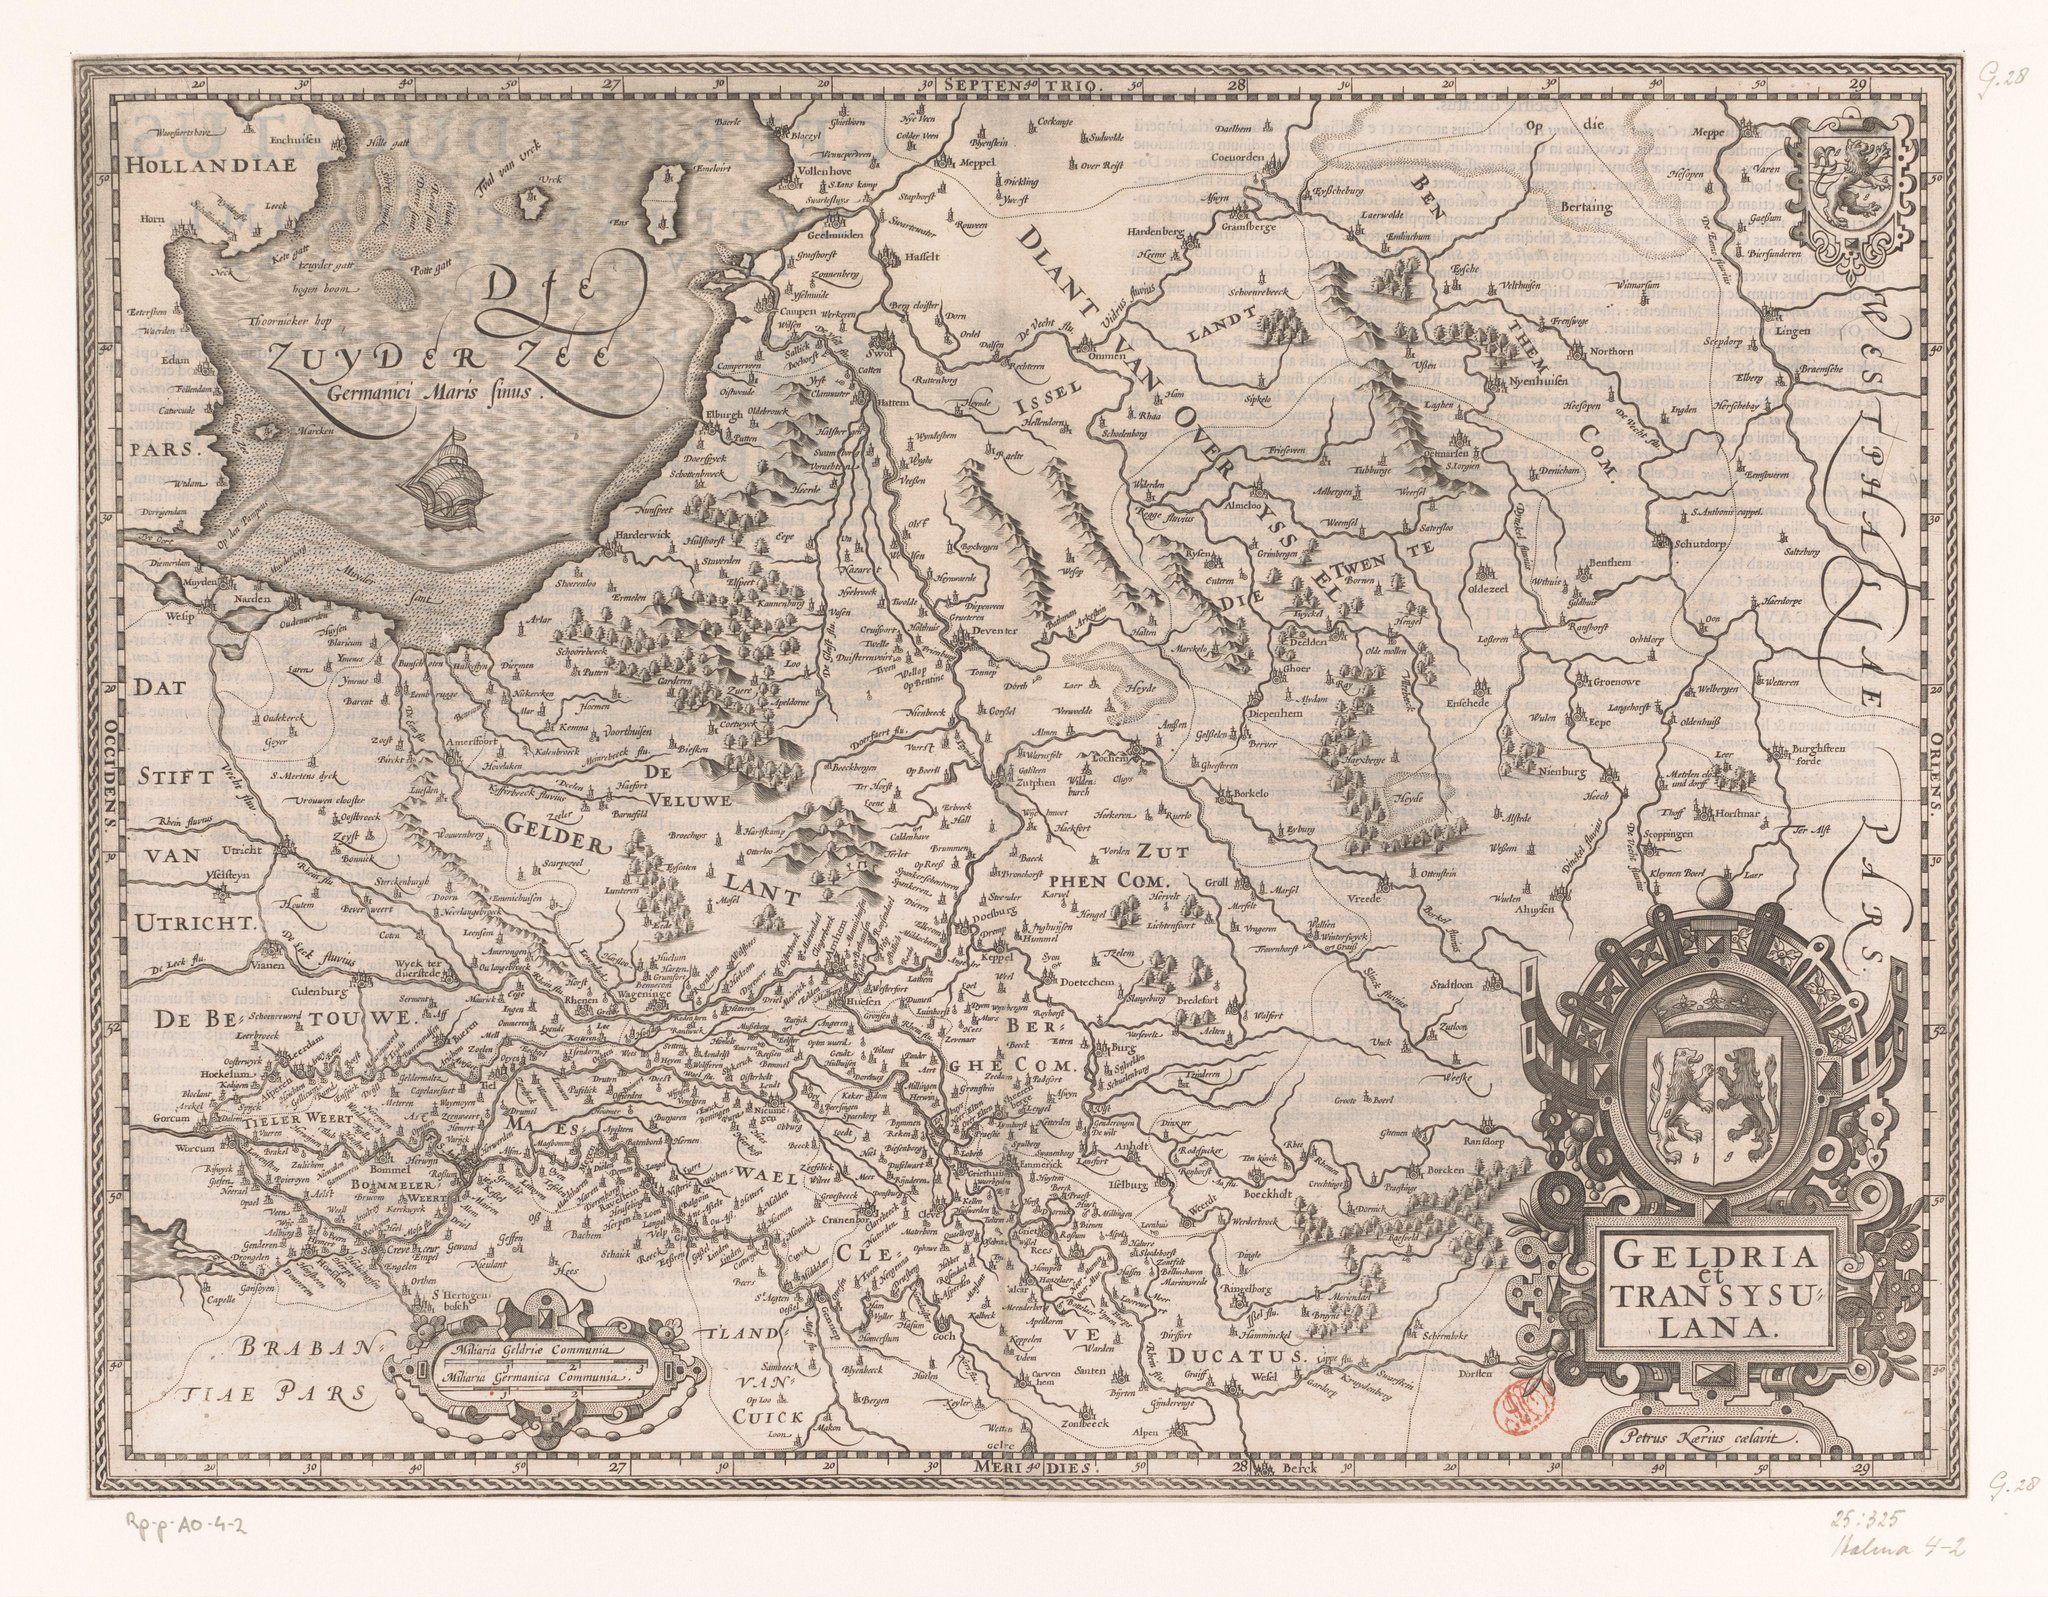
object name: print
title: Kaart van Gelderland en Overijssel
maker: pieter van der keere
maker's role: print maker, publisher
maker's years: 1571-1646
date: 1617-1622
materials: paper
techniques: engraving, letterpress printing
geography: amsterdam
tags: maps of separate countries or regions, coat of arms (as symbol of the state, etc.) (+ province; provincial)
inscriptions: collector's mark: Lugt 2228, collector's mark: Lugt 195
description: Prent gebruikt in: Keere, Pieter van der. Germania inferior id est, provinciarum ejus novae et exactae tabulae geographicae. 1e druk. Amsterdam: Pieter van der Keere, 1617. Of in: Keere, Pieter van der. Germania inferior id est, provinciarum ejus novae et exactae tabulae geographicae. 2e druk. Amsterdam: Pieter van der Keere, 1622.